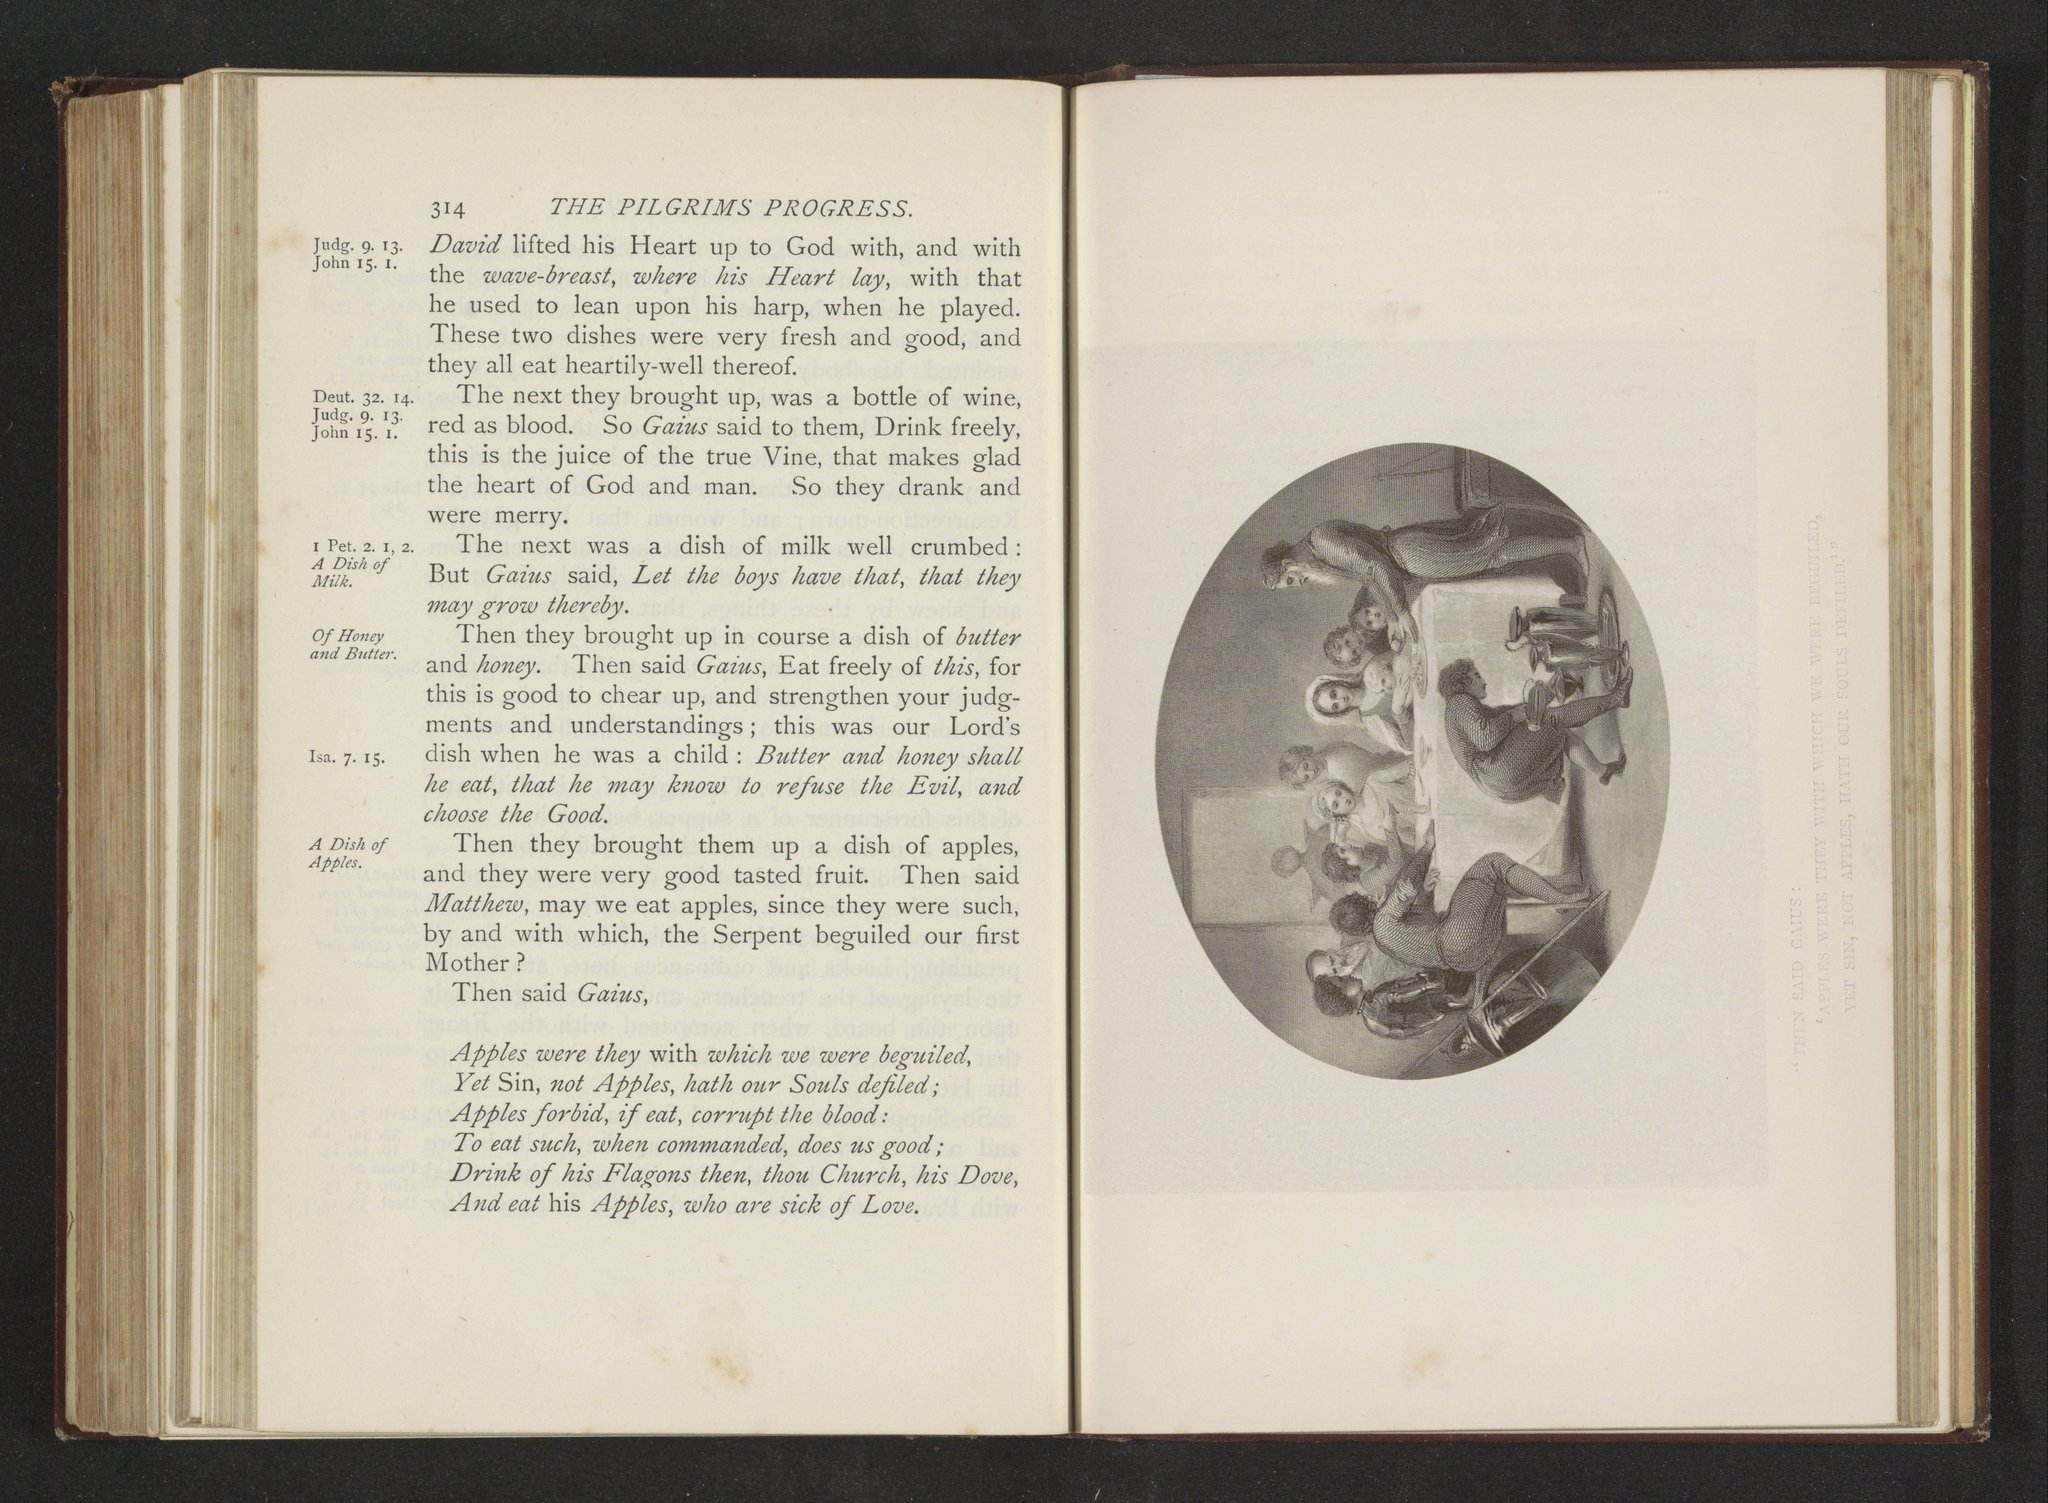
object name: page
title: Fotoreproductie van een illustratie door Thomas Stothard voor Eens Christens reize naar de Eeuwigheid door John Bunyan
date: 1871-1881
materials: paper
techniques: woodburytype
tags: print, e.g.: engraving, etching, lithograph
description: Illustratie betreft een gezelschap aan tafel met Gaius aan het hoofd.